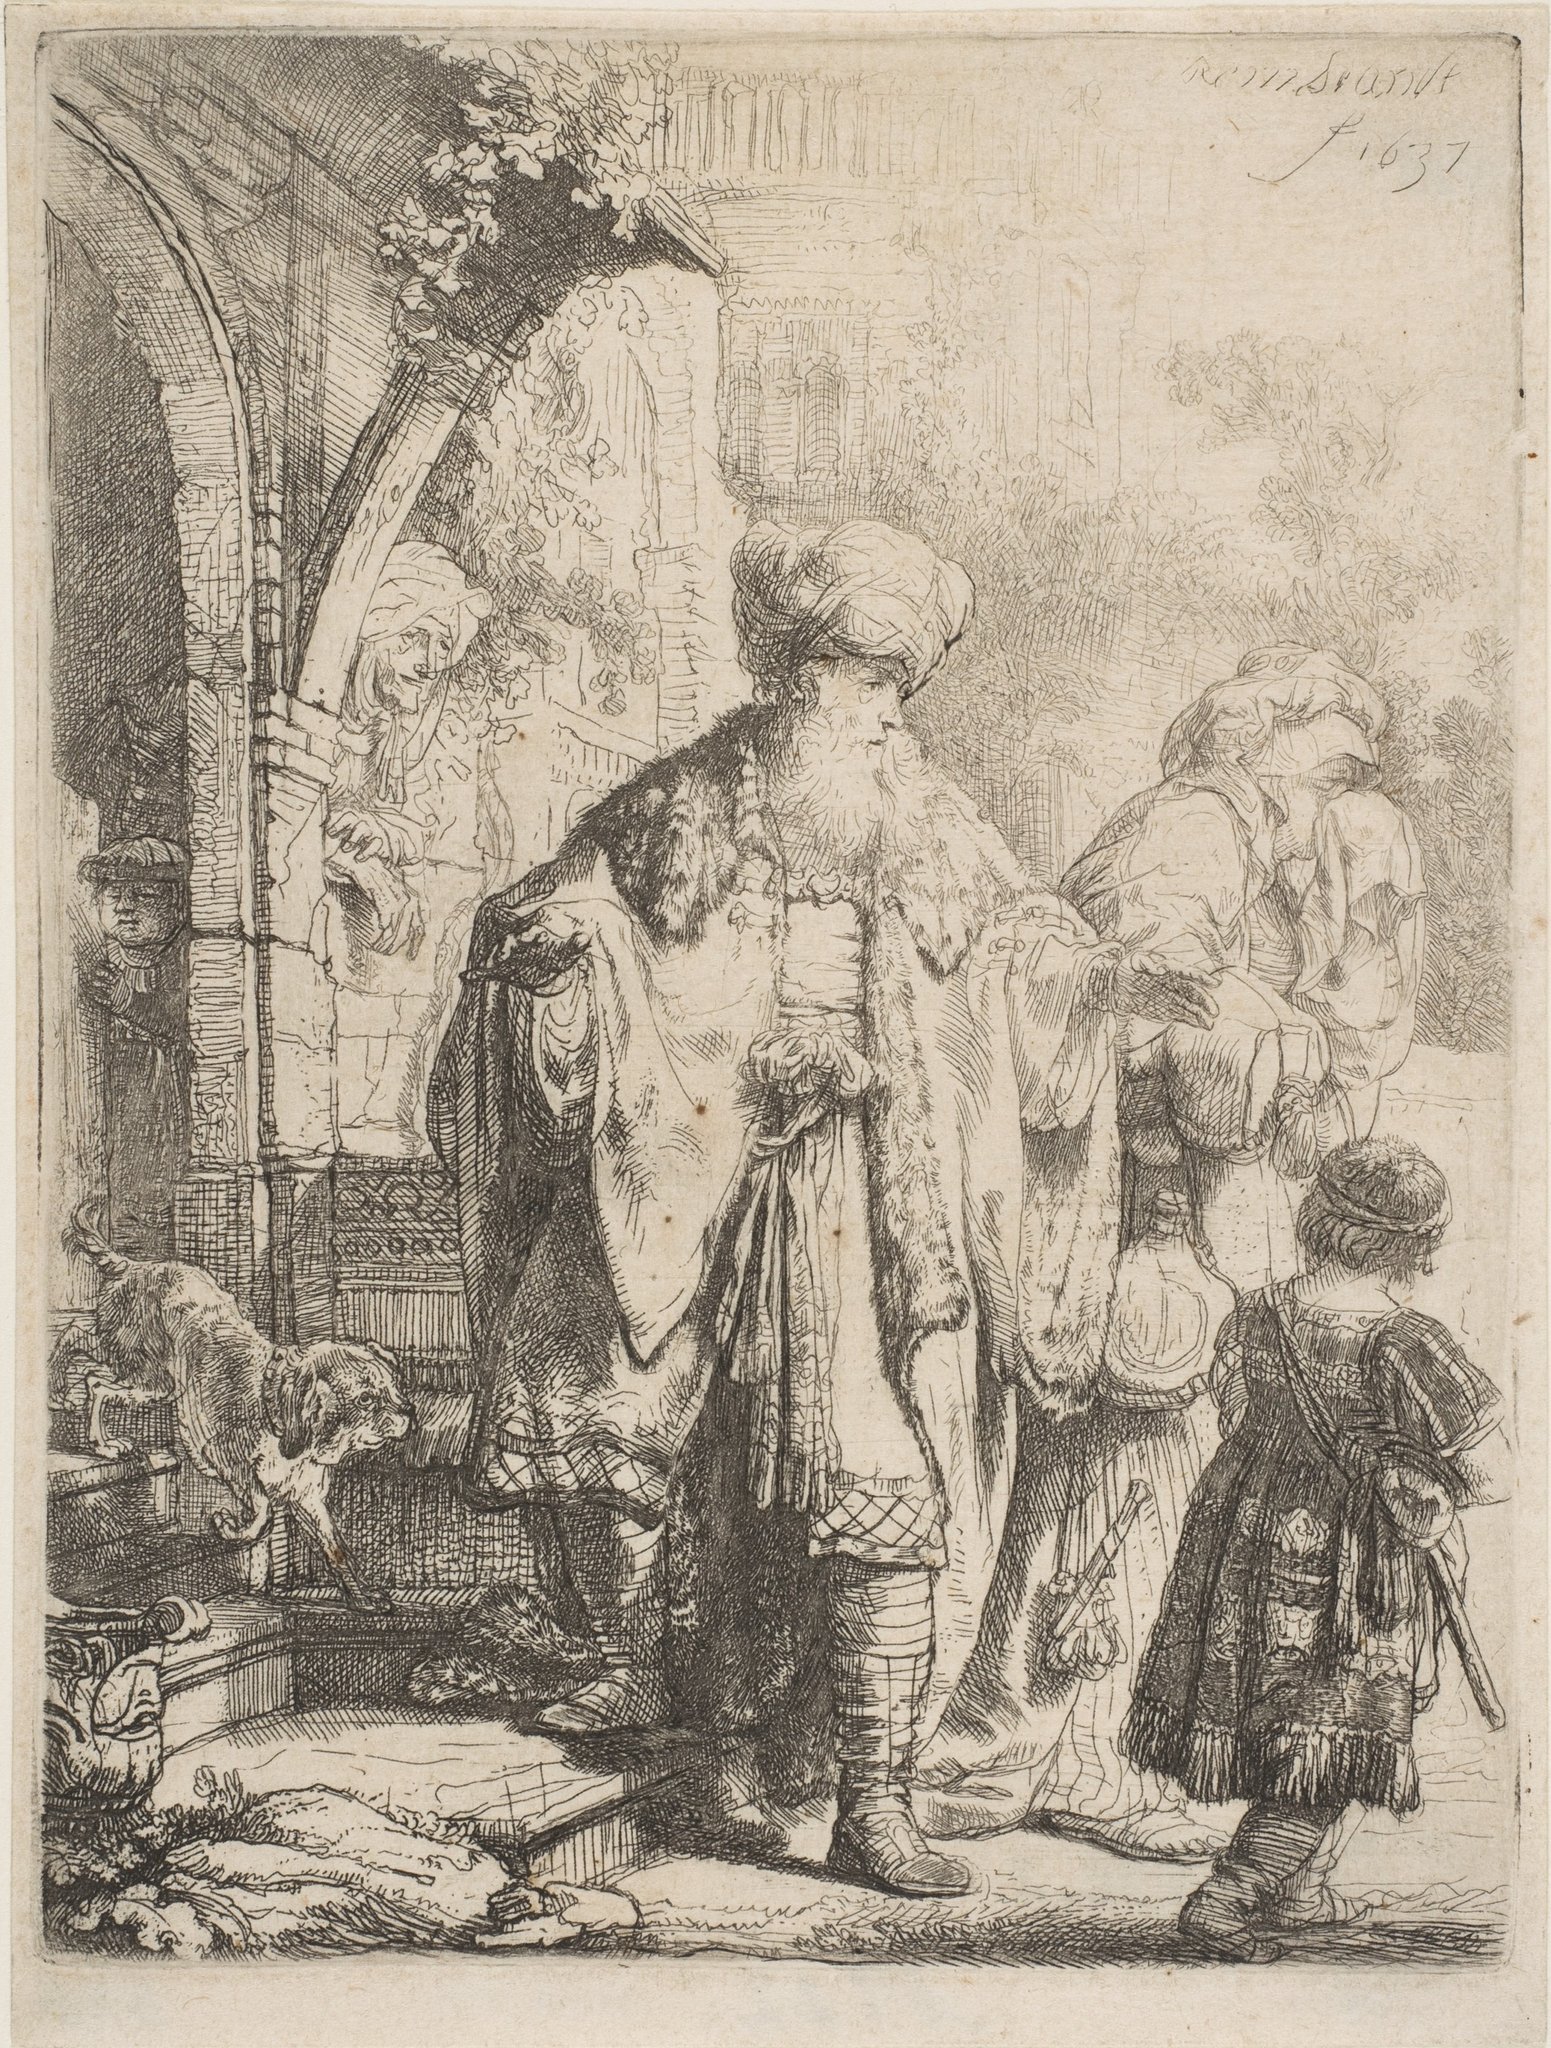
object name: print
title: Abraham Casting out Hagar and Ishmael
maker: rembrandt van rijn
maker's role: artist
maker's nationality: dutch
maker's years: 1606-1669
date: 1637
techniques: drypoint, etching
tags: children,men,dogs,abraham